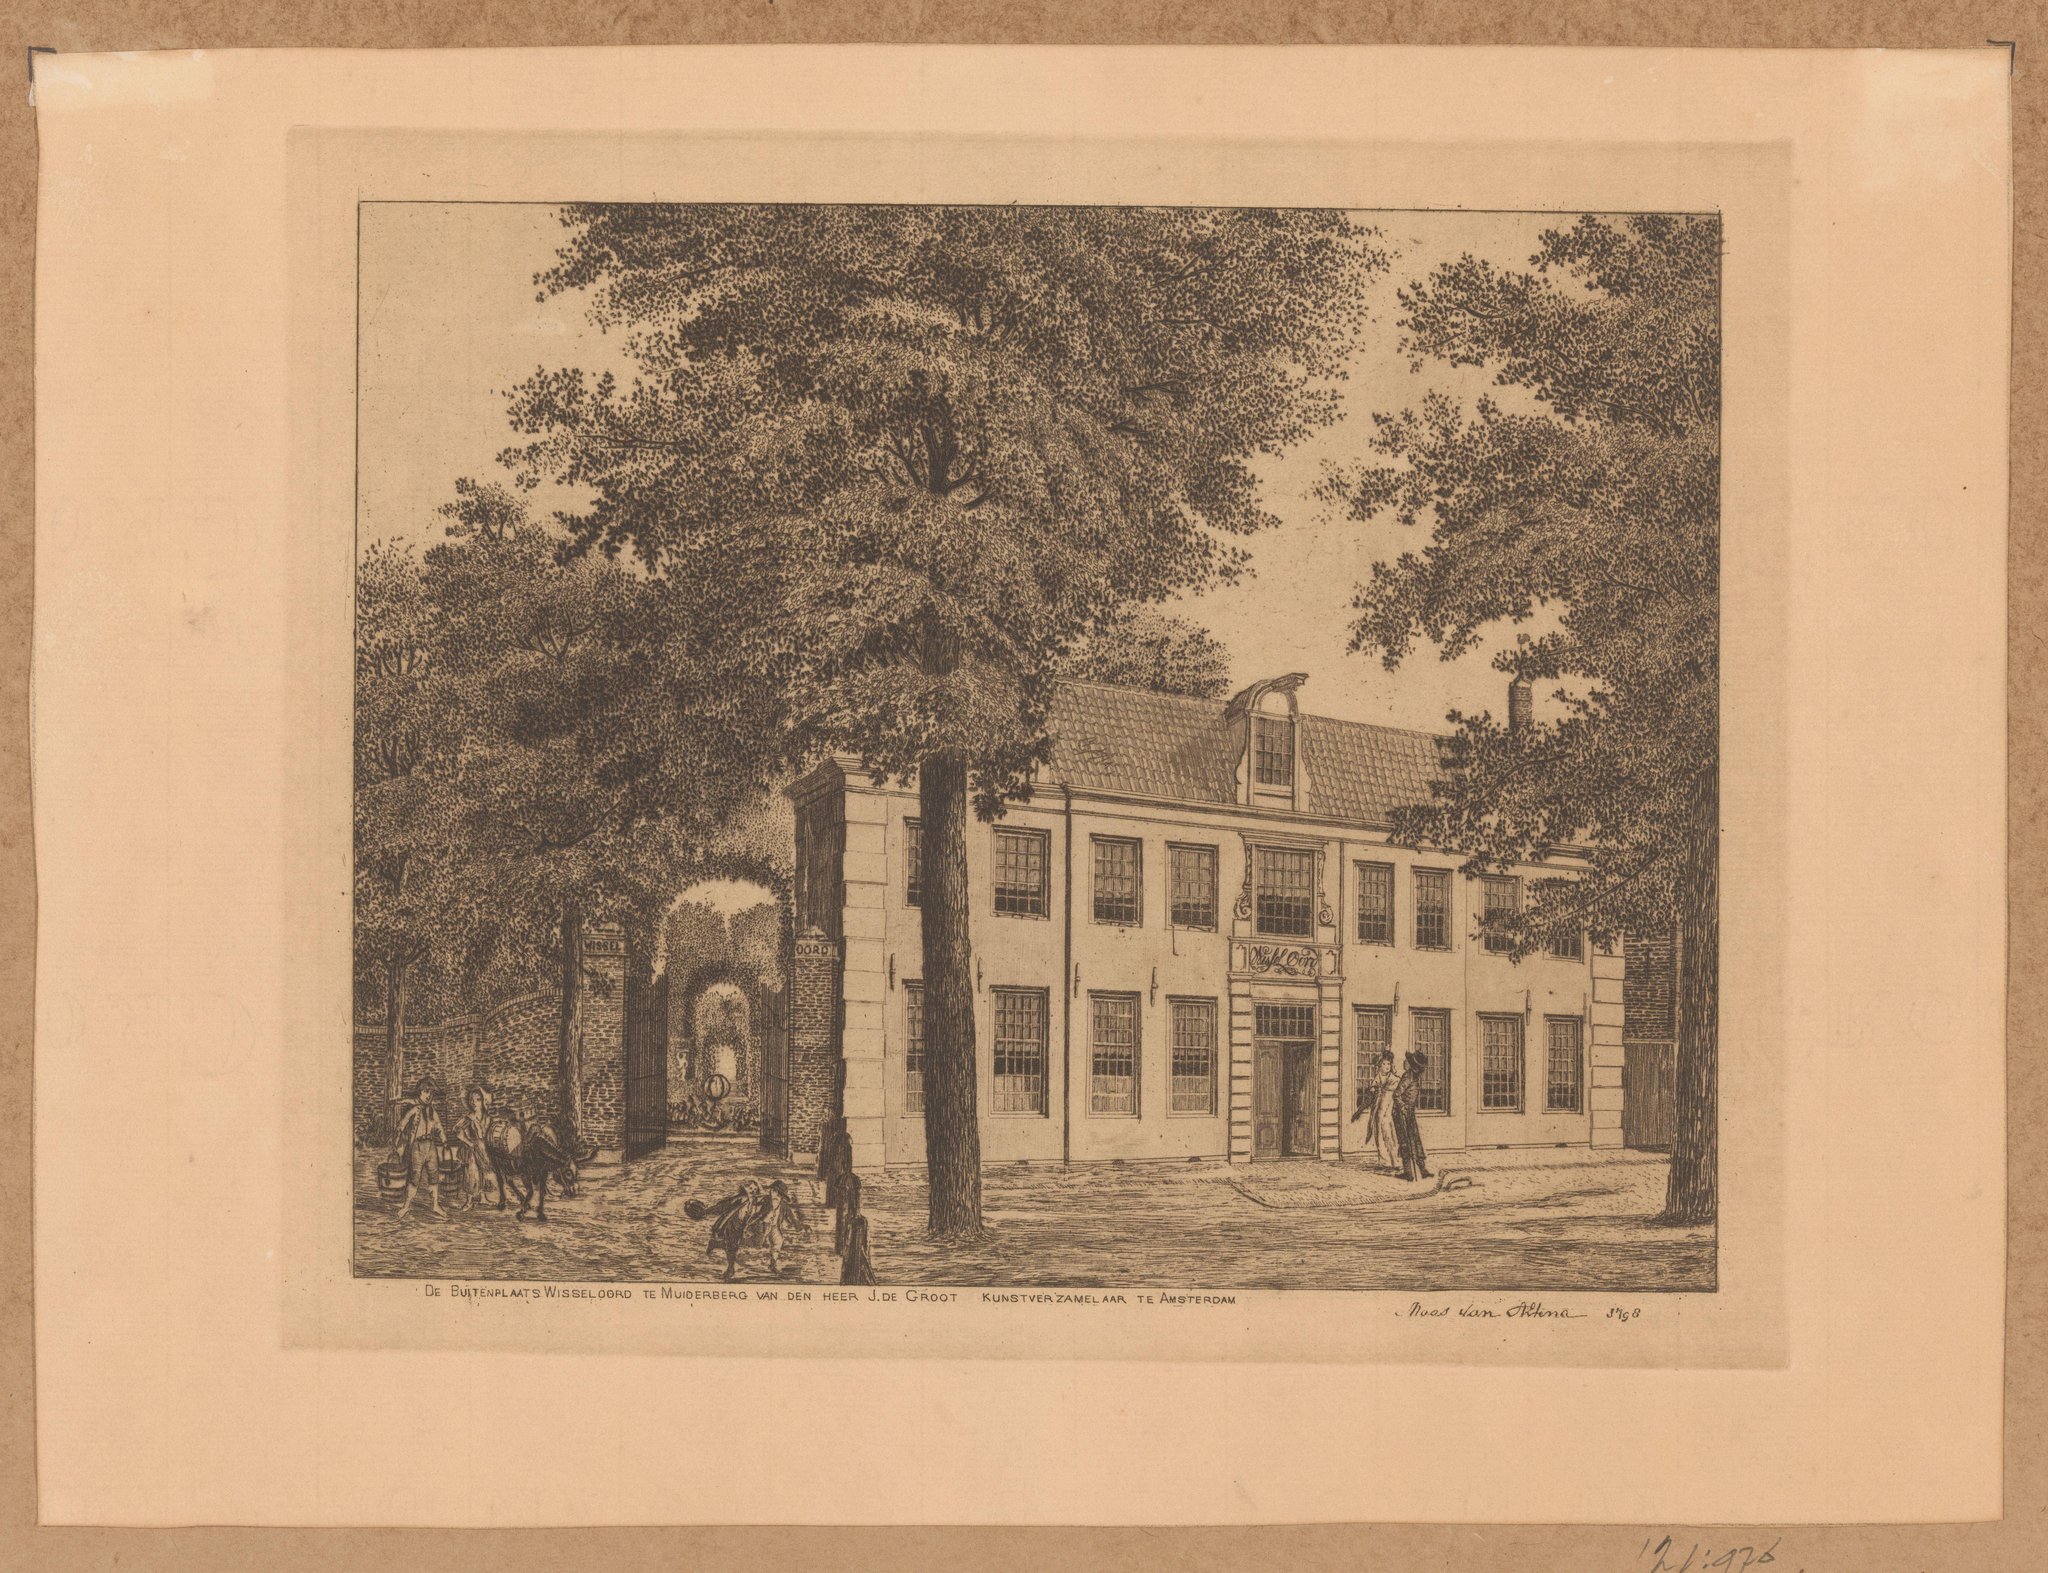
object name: print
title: De Buitenplaats Wisseloord te Muiderberg van den Heer J. de Groot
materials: paper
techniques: etching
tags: rural housing, e.g. country-house, villa, cottage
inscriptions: collector's mark: Lugt 2233